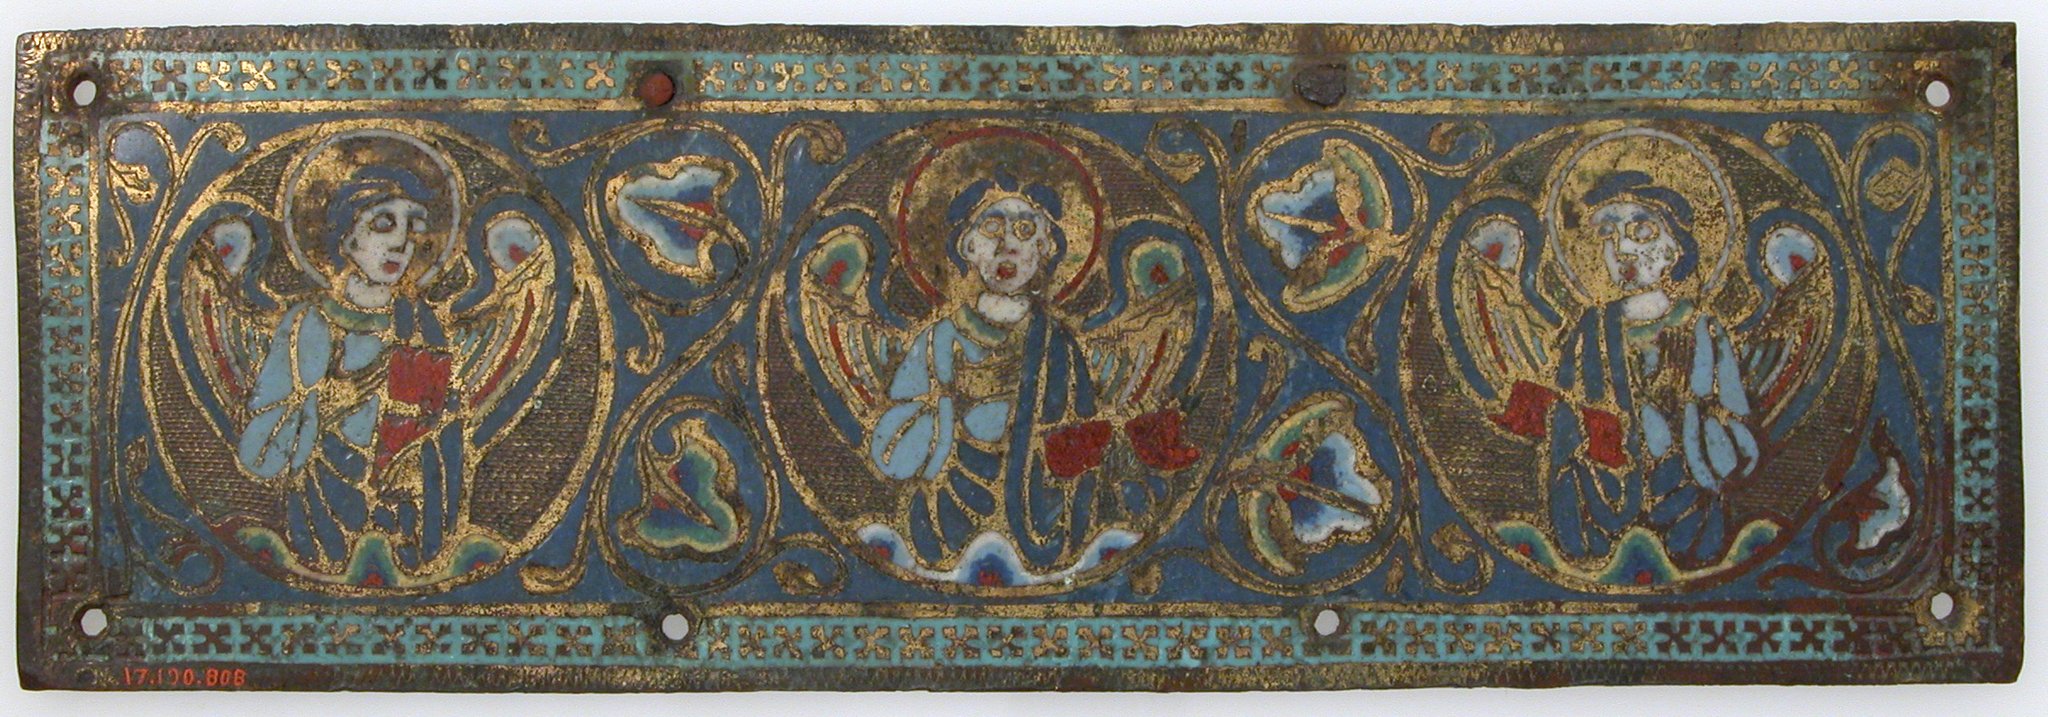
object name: plaque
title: Plaque from a Chasse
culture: french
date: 1201-1300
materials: gilt copper, enamel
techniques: enamel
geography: france